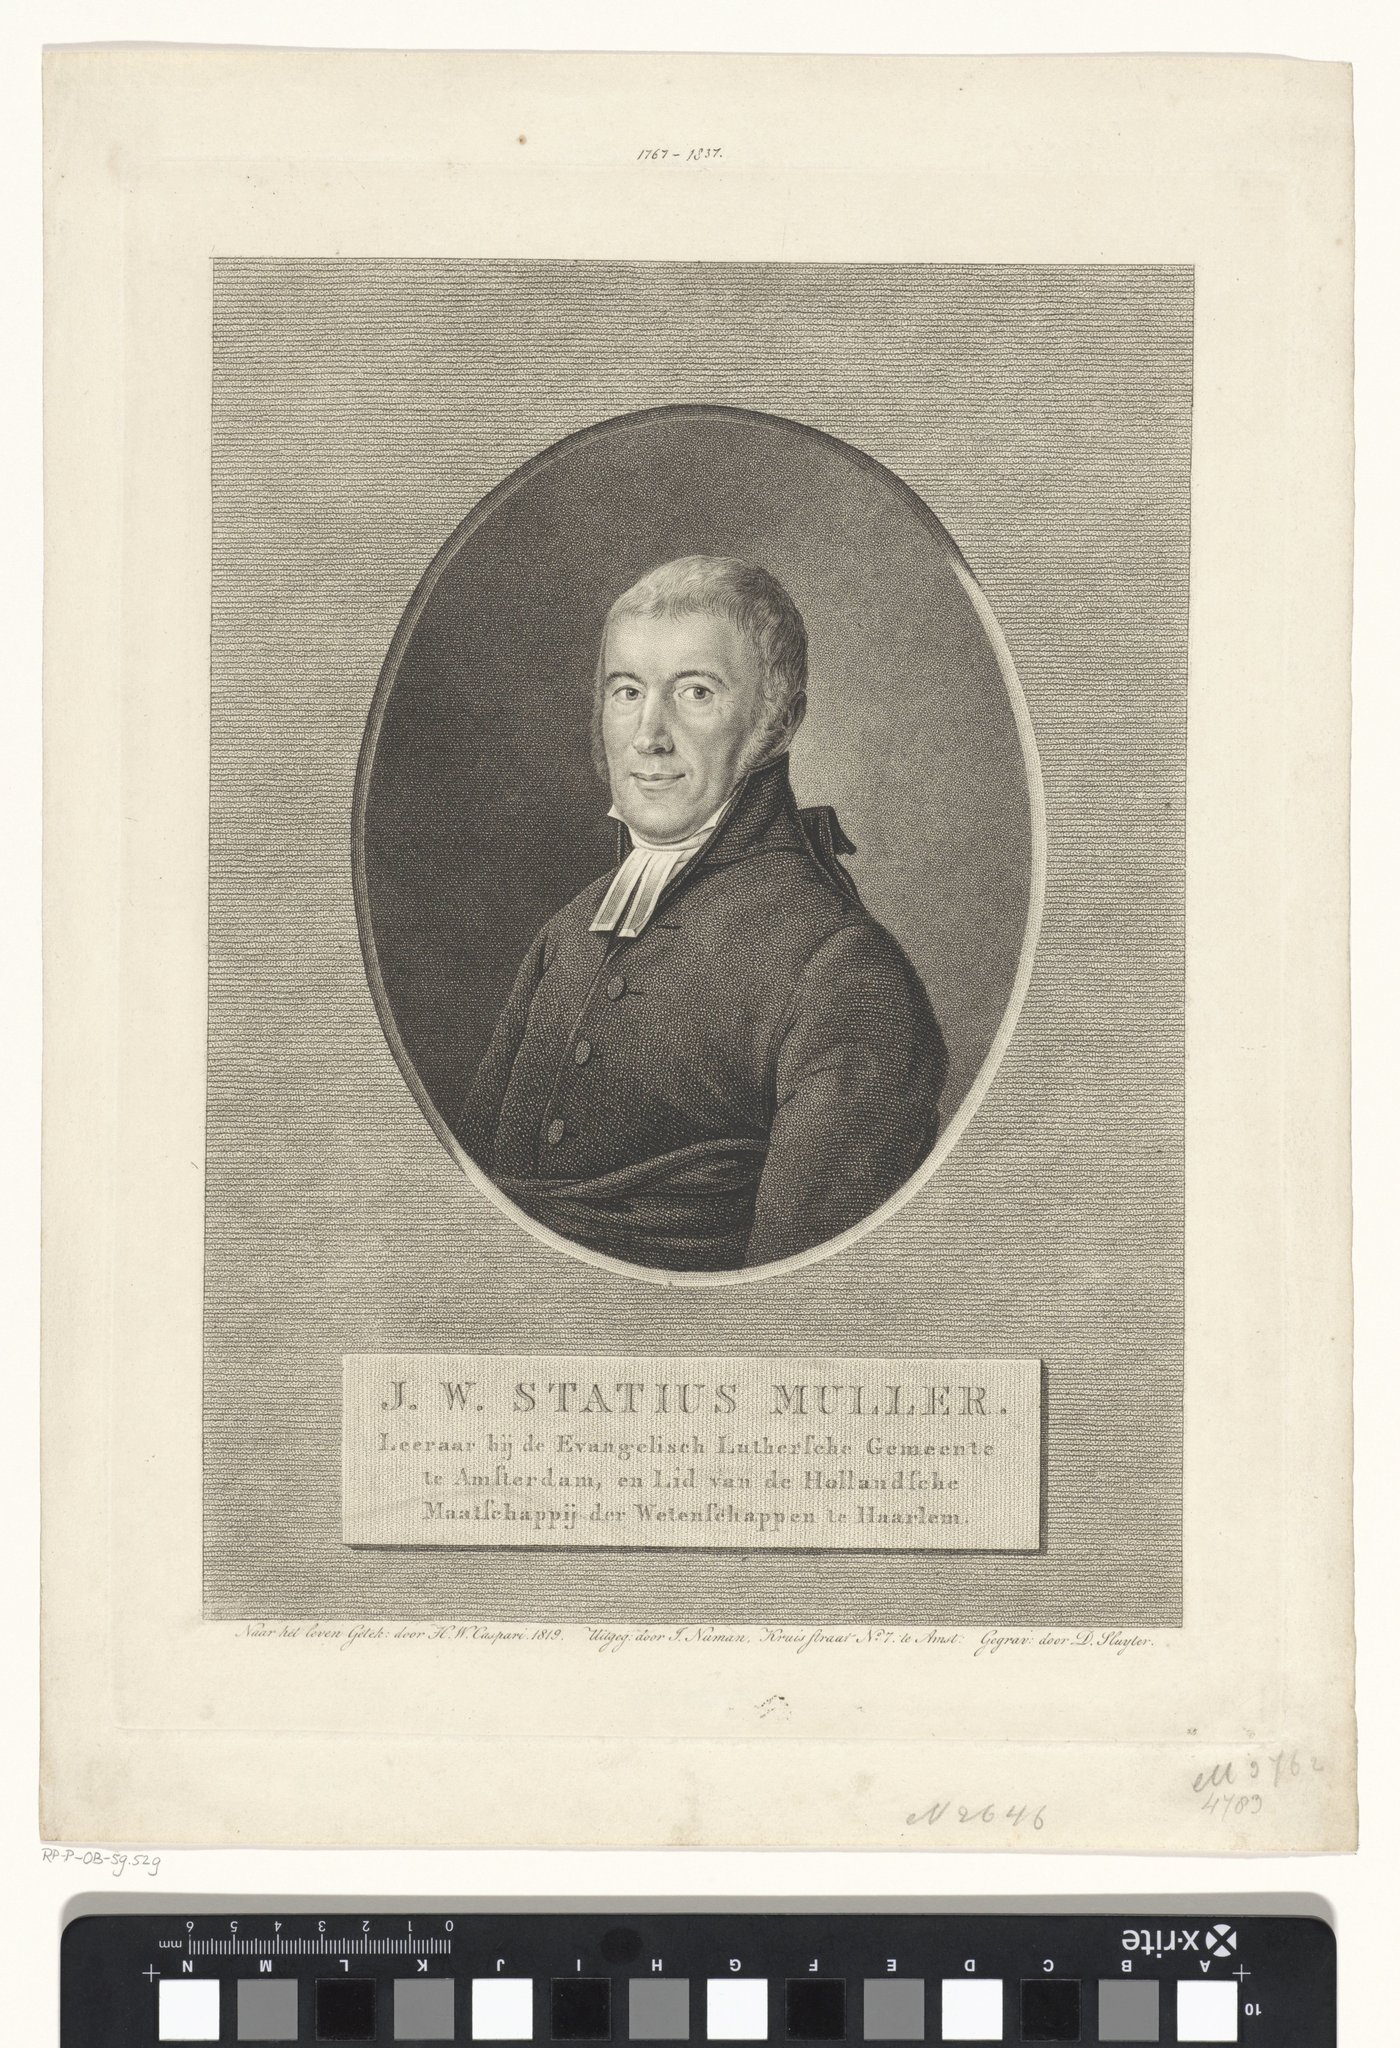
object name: print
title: Portret van Johan Wilhelm Statius Muller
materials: paper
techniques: engraving, etching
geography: amsterdam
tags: maastricht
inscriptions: collector's mark: Lugt 2228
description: Portret van Johan Wilhelm Statius Muller, predikant en lid van de Hollandsche Maatschappij der Wetenschappen in Haarlem.